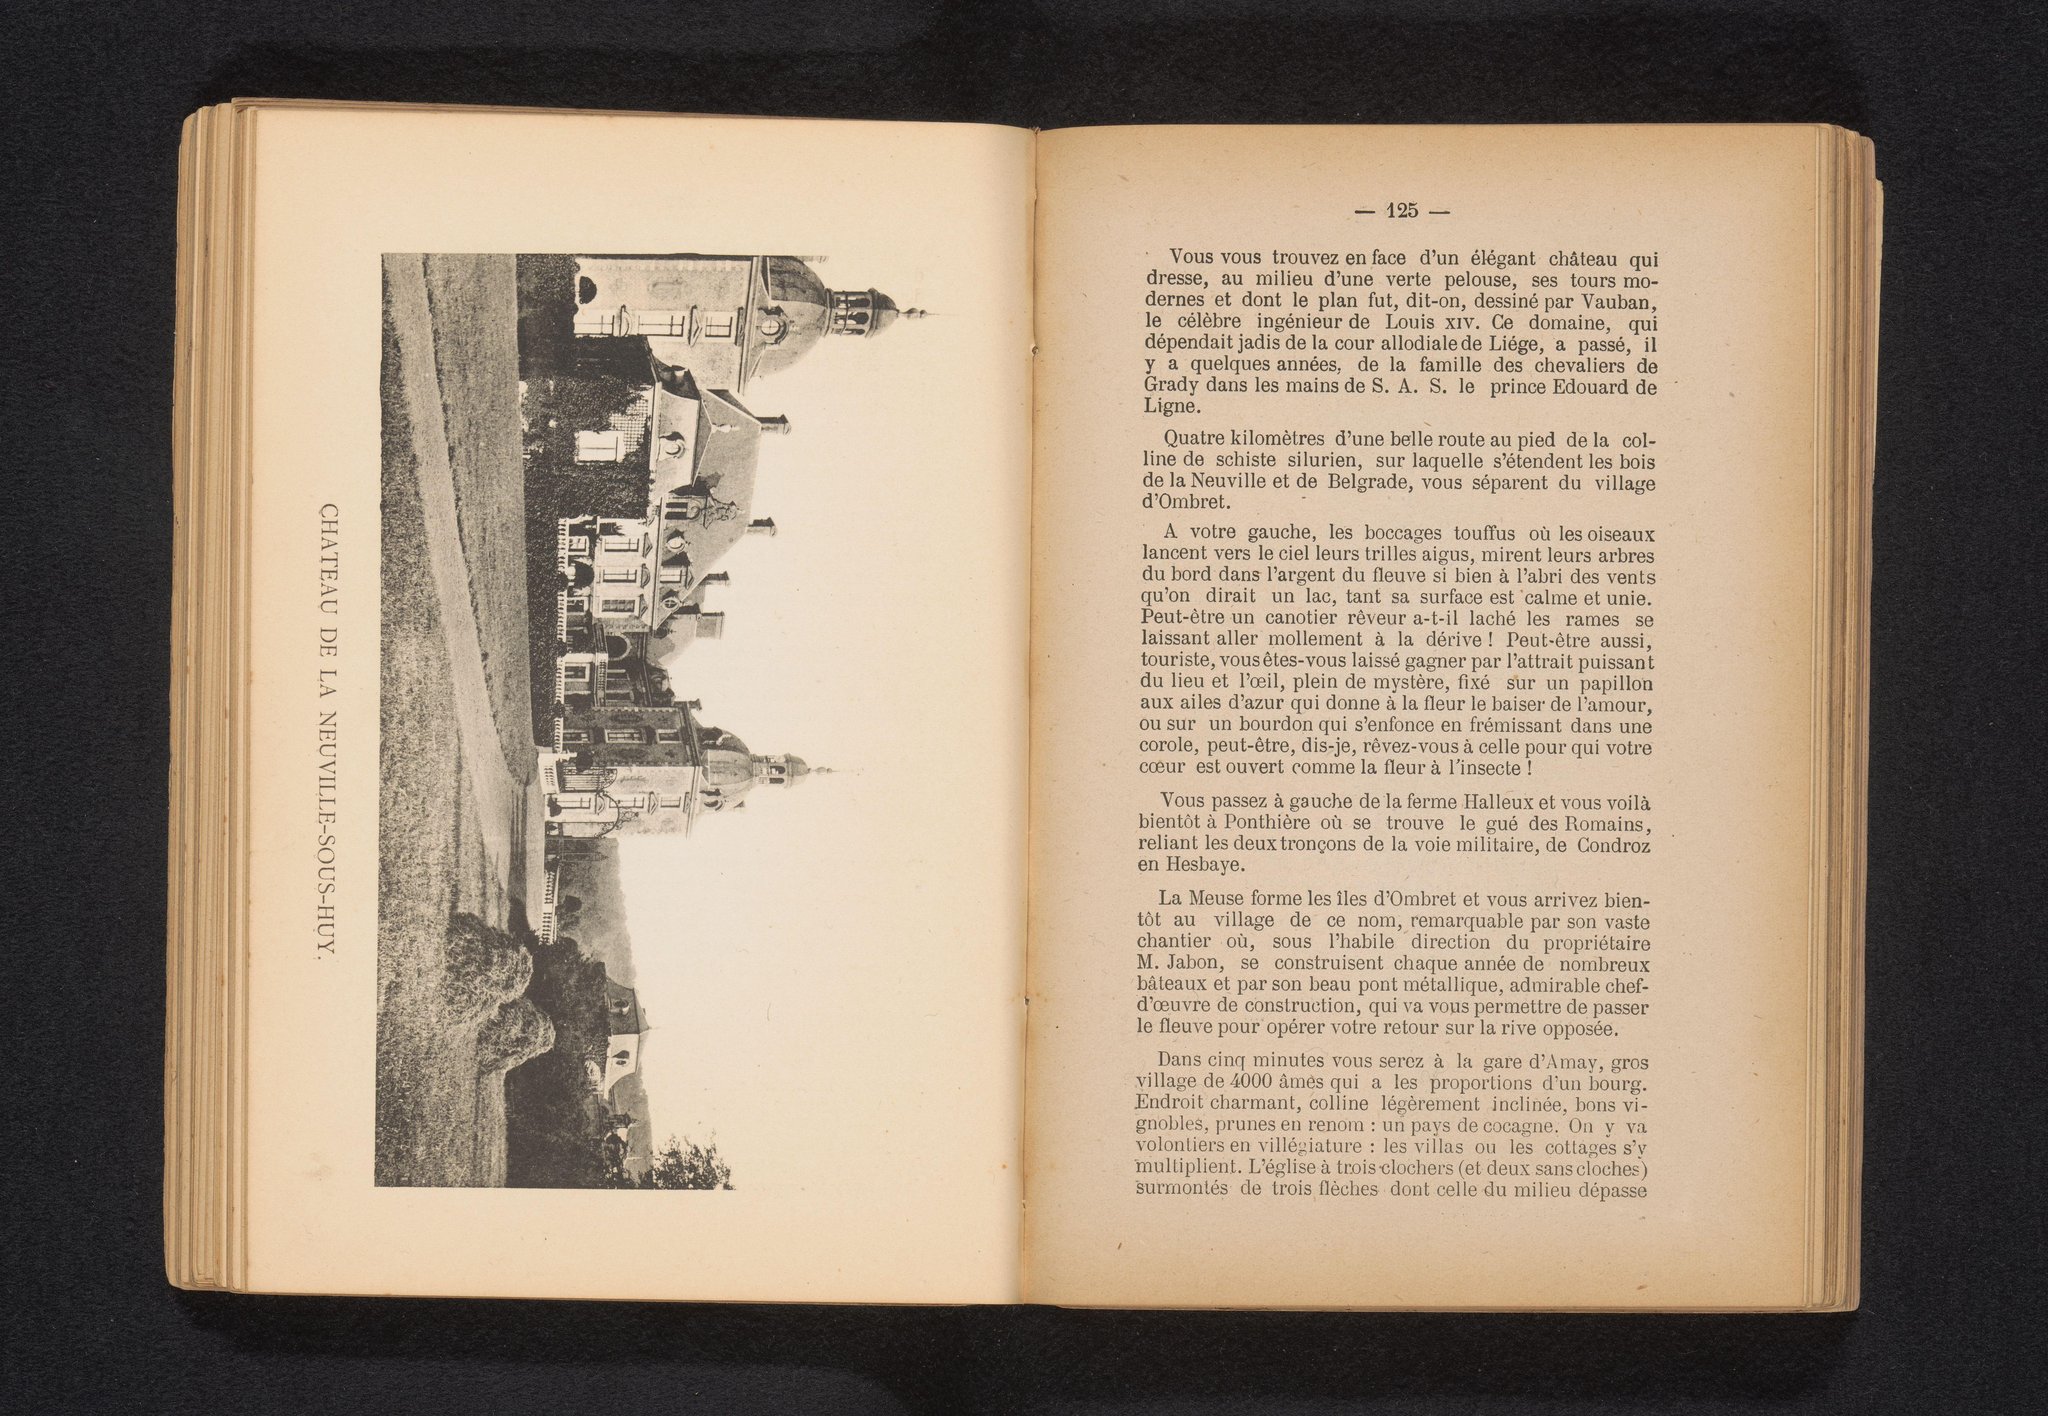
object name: photomechanical print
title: Chateau de la Neuville-sous-Huy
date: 1885-1890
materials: paper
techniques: photograph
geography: brussels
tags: castle